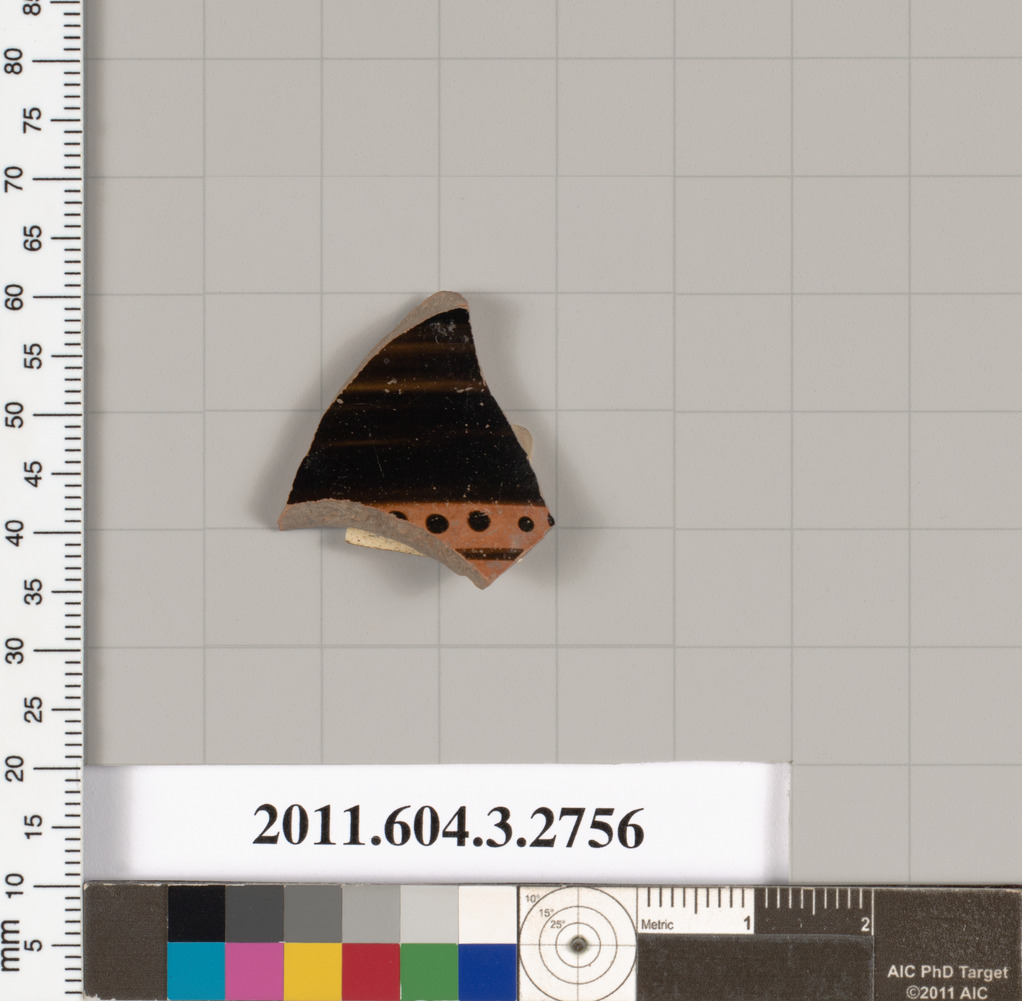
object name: chou fragment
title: Terracotta fragment of an oinochoe: chous (jug)?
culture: greek, attic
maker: class of vatican g 50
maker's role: artist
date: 534-468 BCE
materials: terracotta